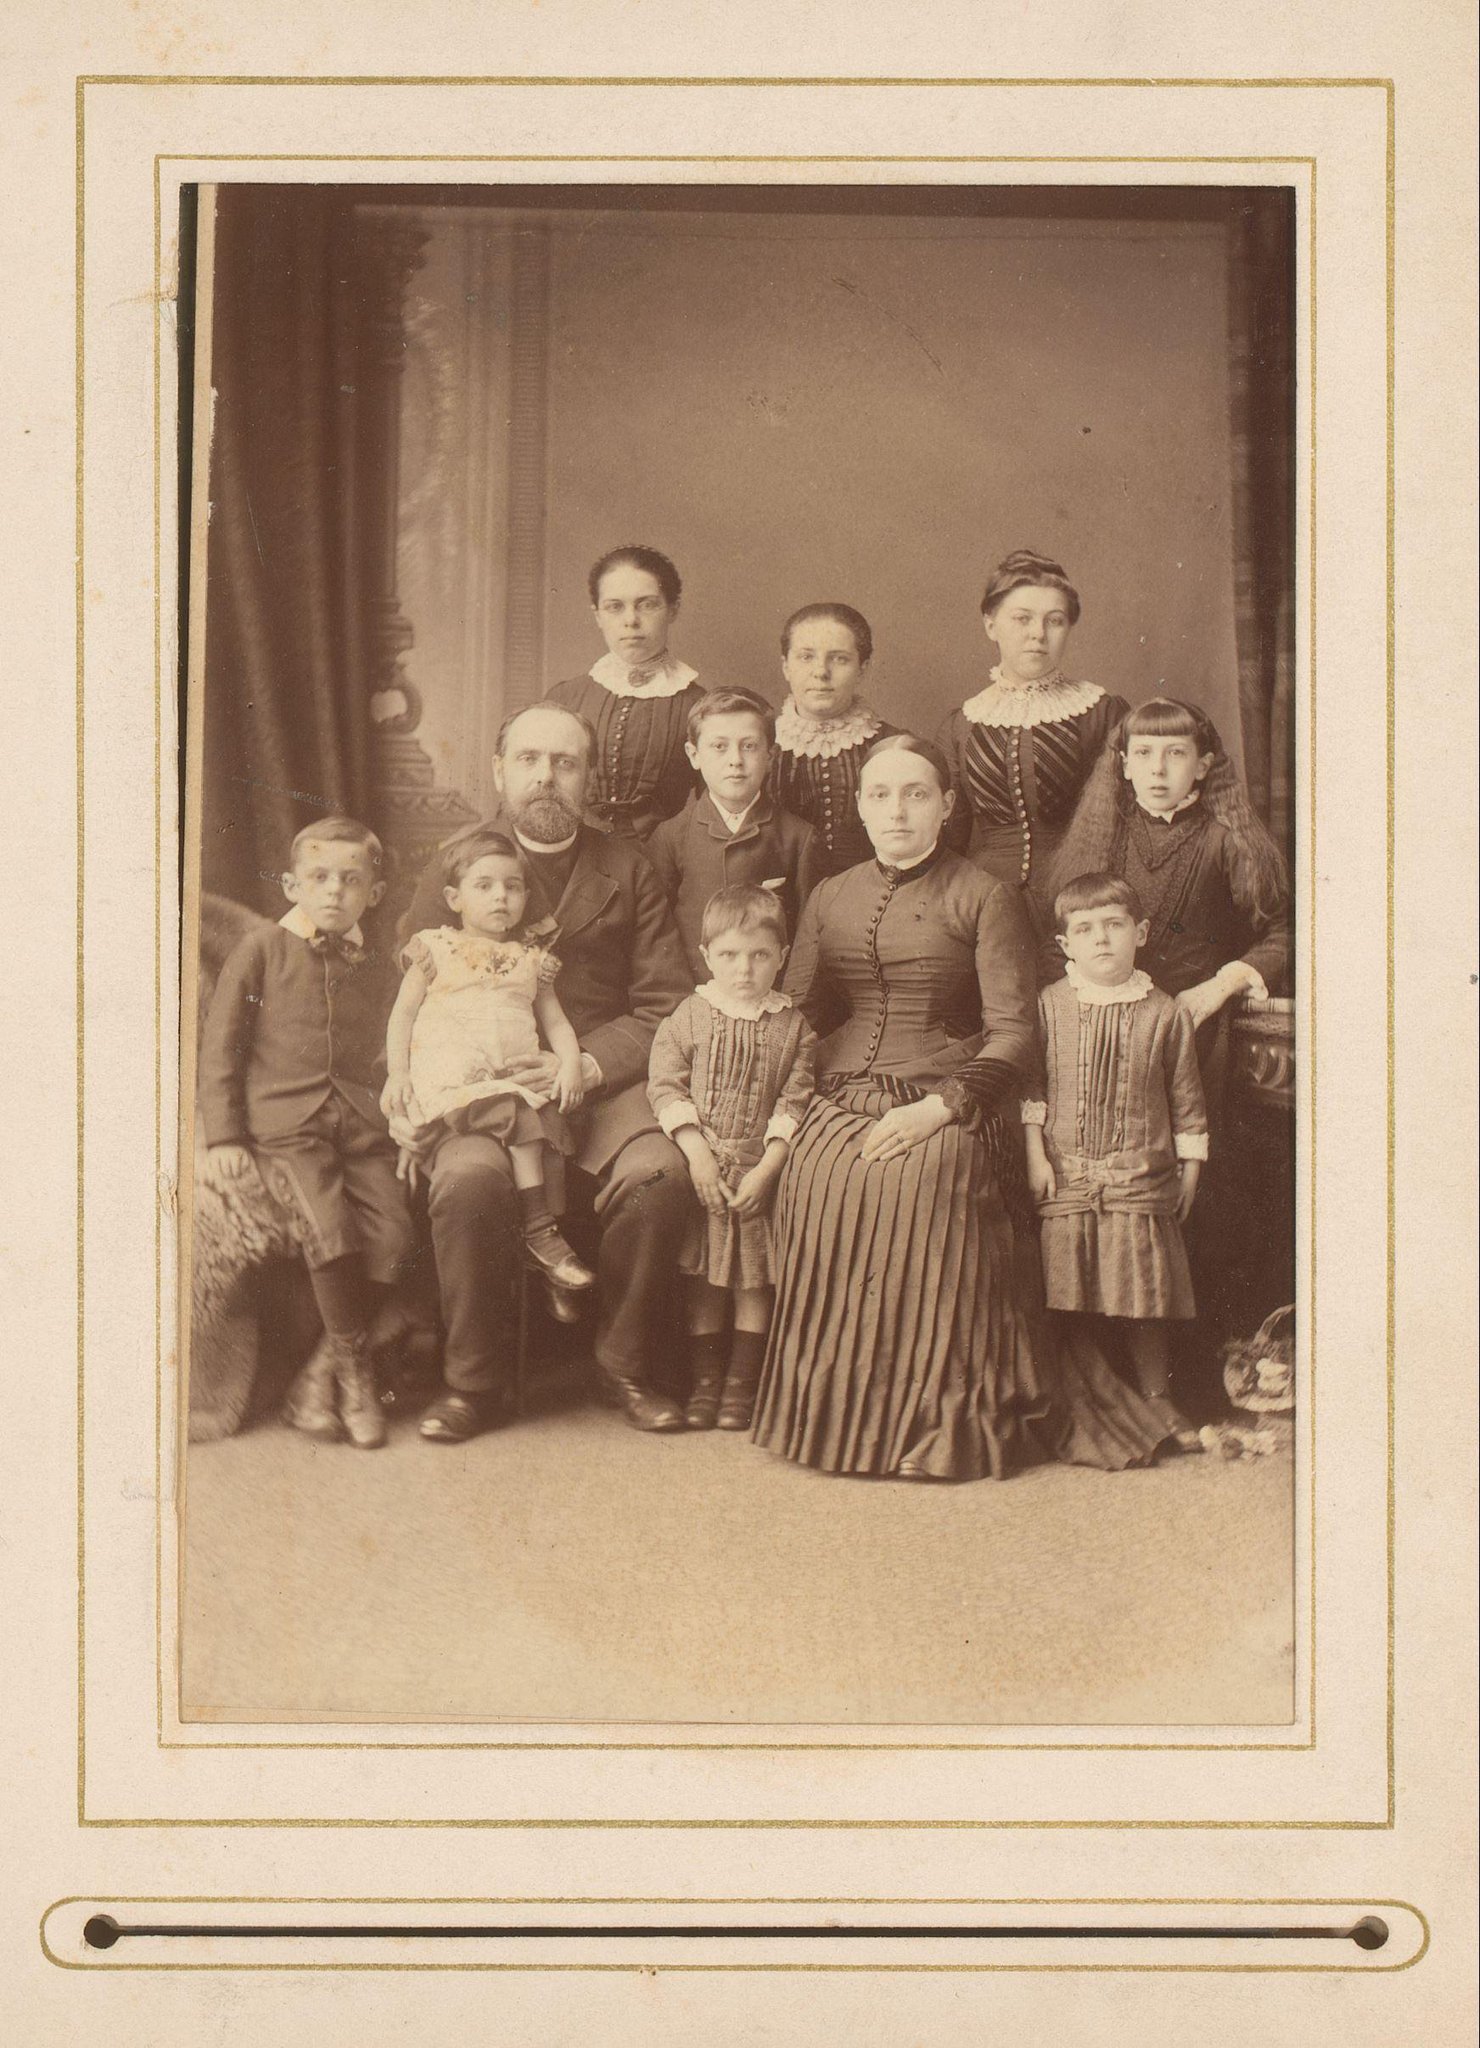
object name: album leaf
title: Familieportret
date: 1860-1900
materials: cardboard, photographic support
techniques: albumen print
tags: family life, anonymous historical persons portrayed in a group, in a group-portrait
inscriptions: inscription: ‘Photographers/ to her majesty the queen/ (...)/ A. & G. Taylor/ Furnival Chambers, 101 Norfolk Street/ Sheffield/ (...)’